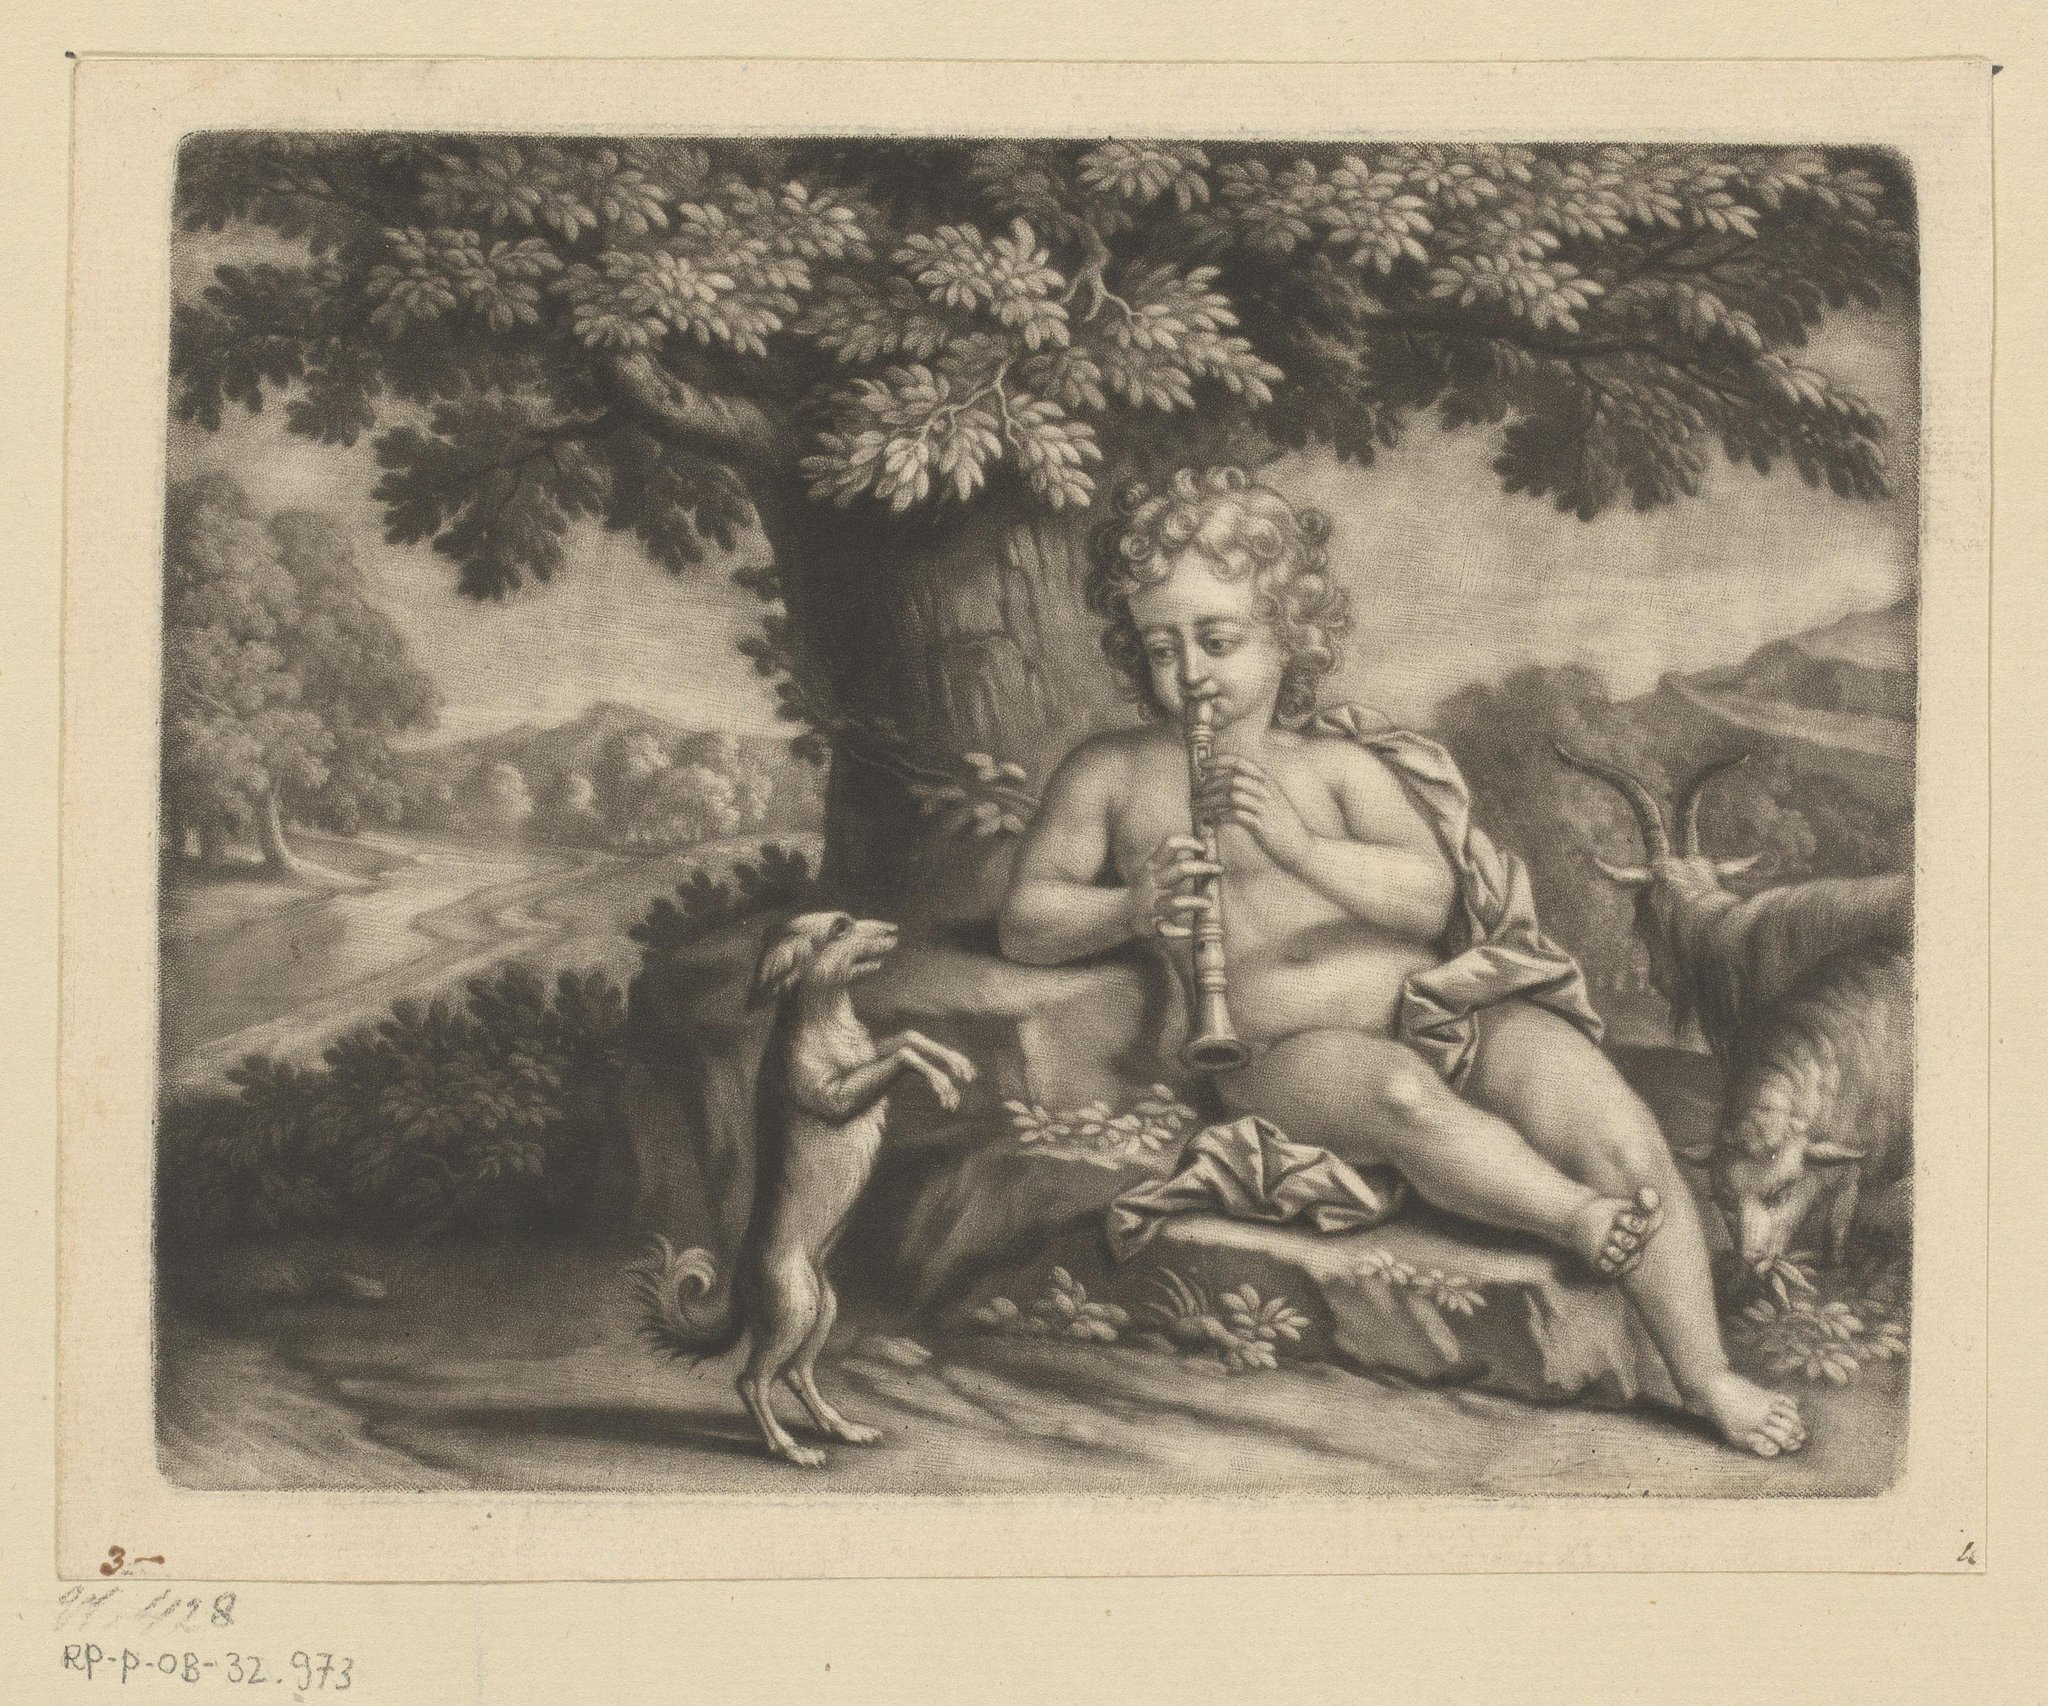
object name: print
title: Jongen speelt fluit voor een hond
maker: john smith (prentmaker/ uitgever)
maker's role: print maker, publisher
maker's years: 1652-1743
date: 1662-1742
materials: paper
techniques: mezzotint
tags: boy (child between toddler and youth), flute, aulos, tibia - cc - out of doors, dog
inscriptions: collector's mark: Lugt 240